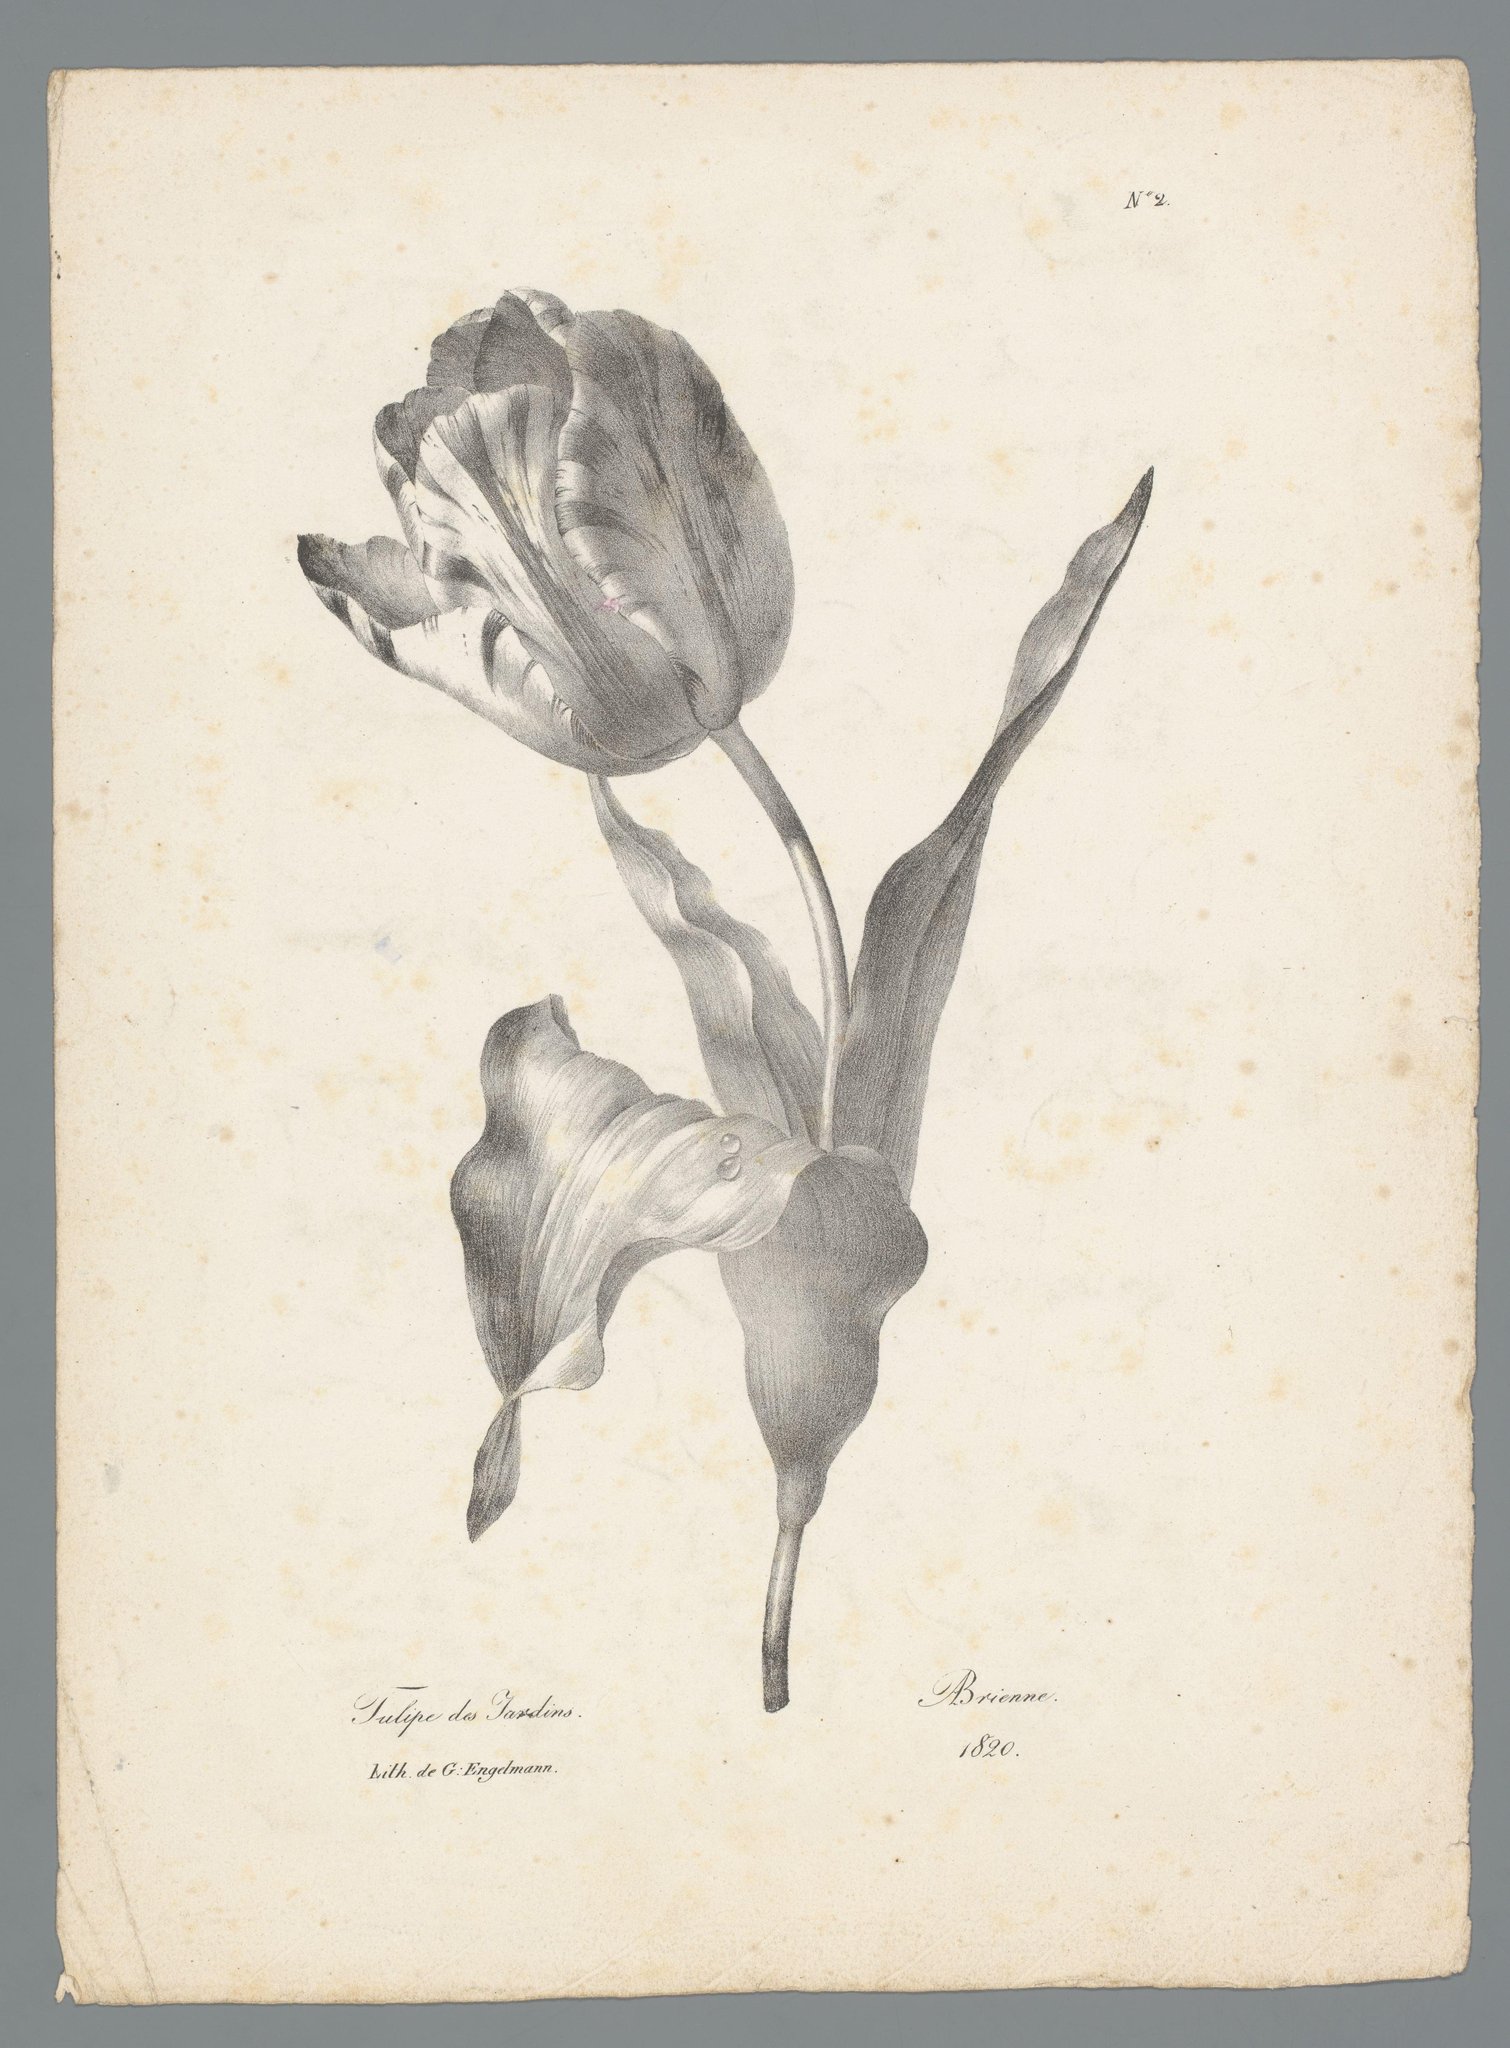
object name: print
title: Tulipe des jardins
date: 1820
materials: paper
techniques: lithograph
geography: paris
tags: flowers: tulip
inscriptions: collector's mark: Lugt 2233